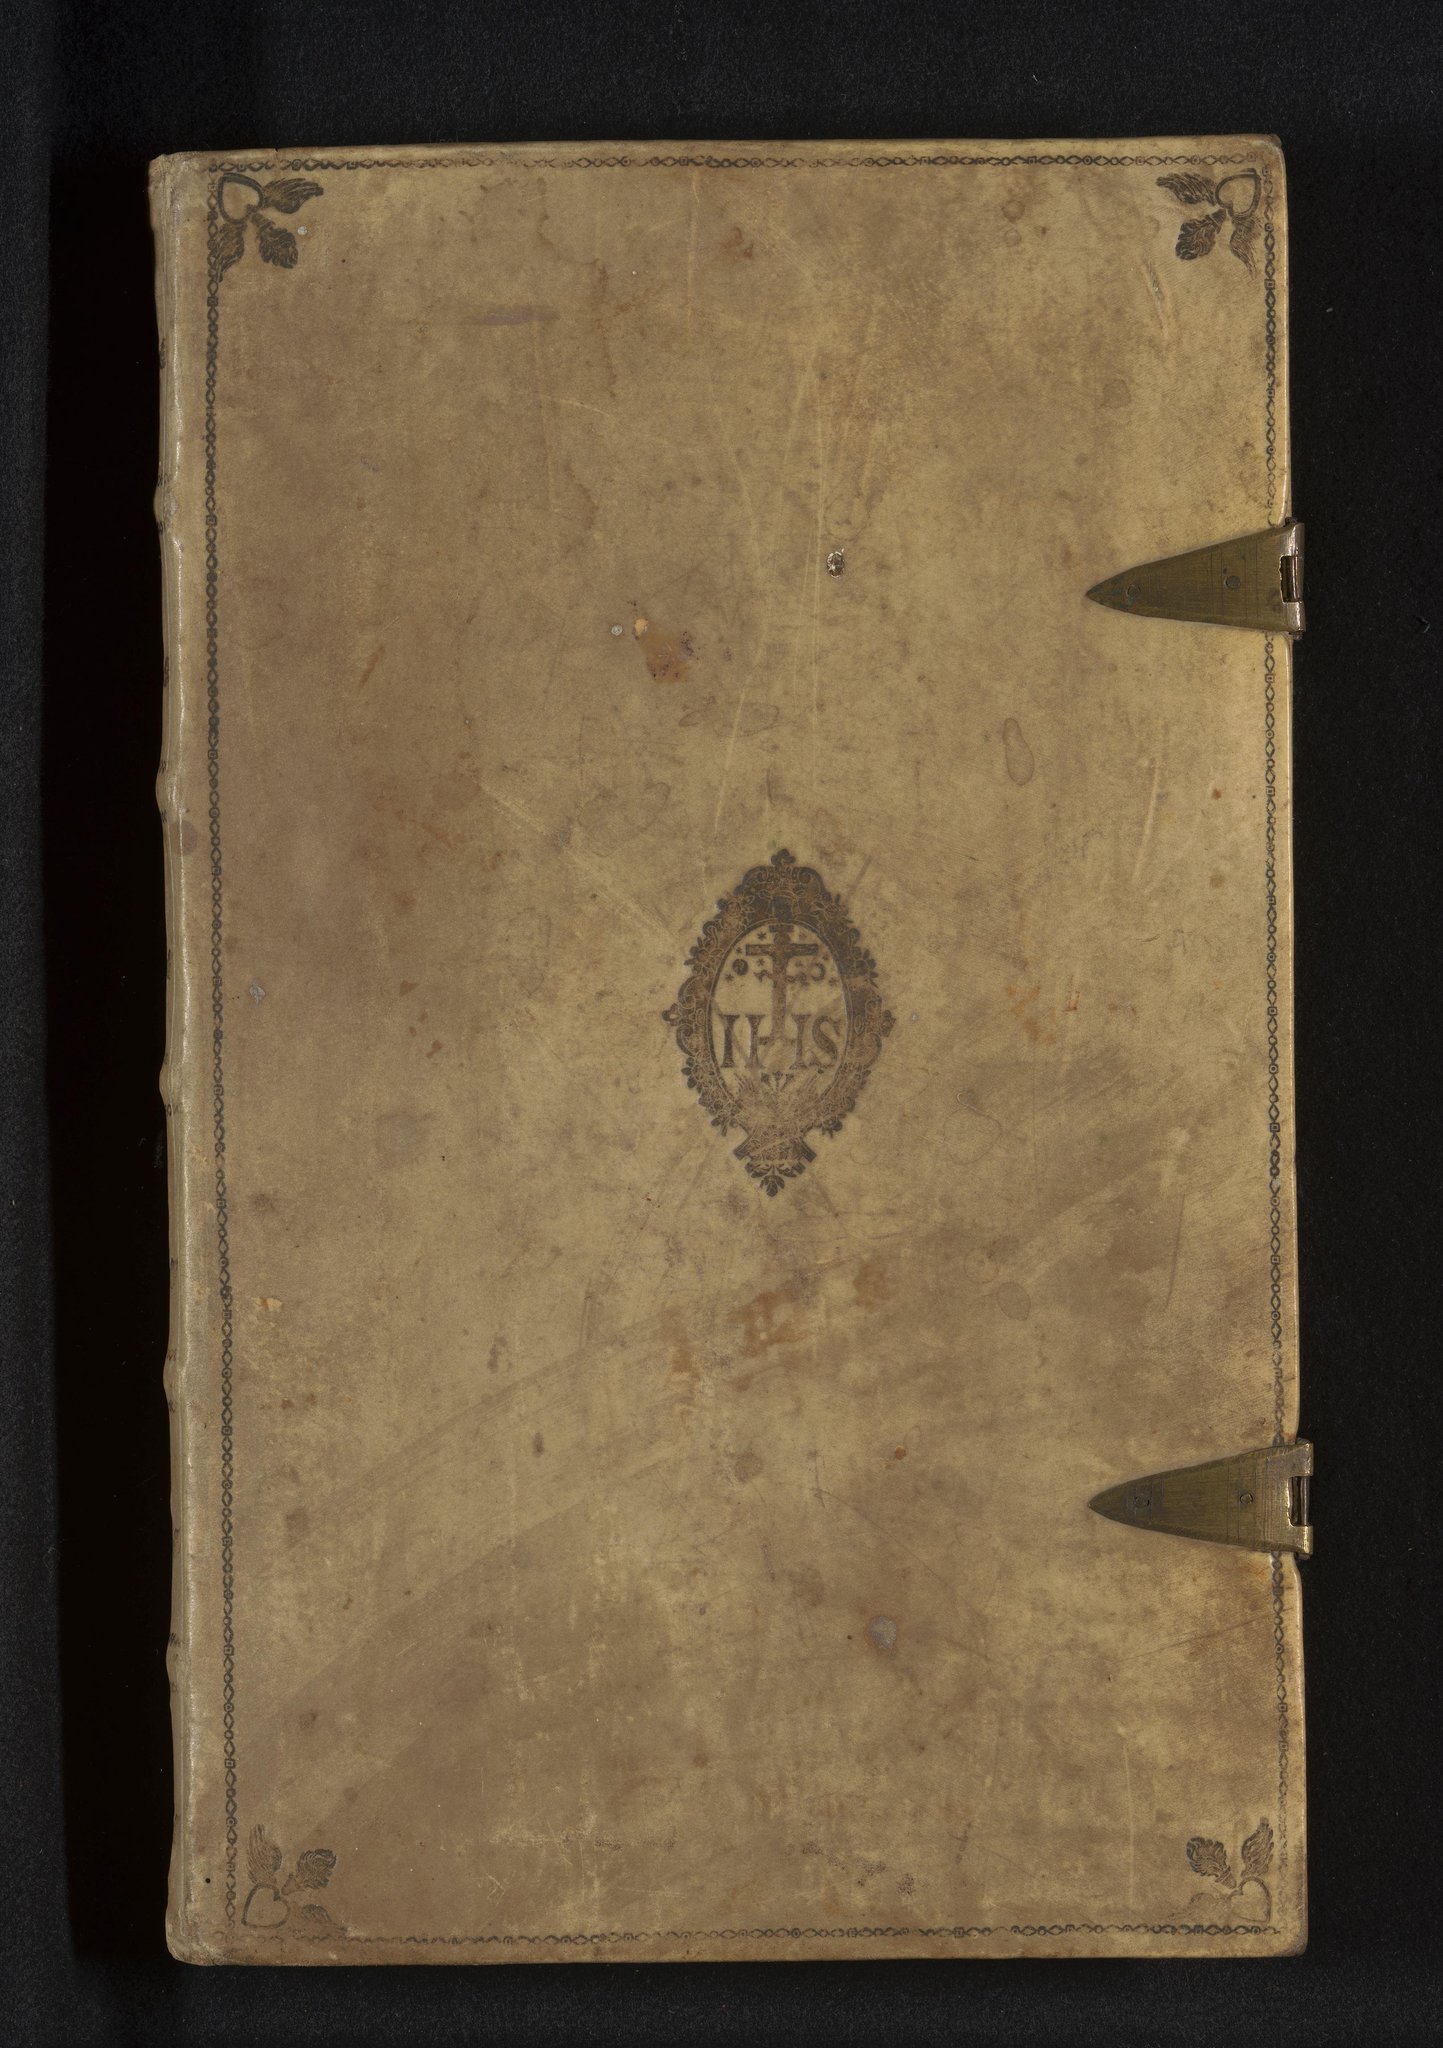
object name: prentrecueil, prentenalbum, prentalbum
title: Prentalbum met voornamelijk christelijke voorstellingen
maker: Anonymous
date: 1670-1699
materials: brass, paper, parchment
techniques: engraving